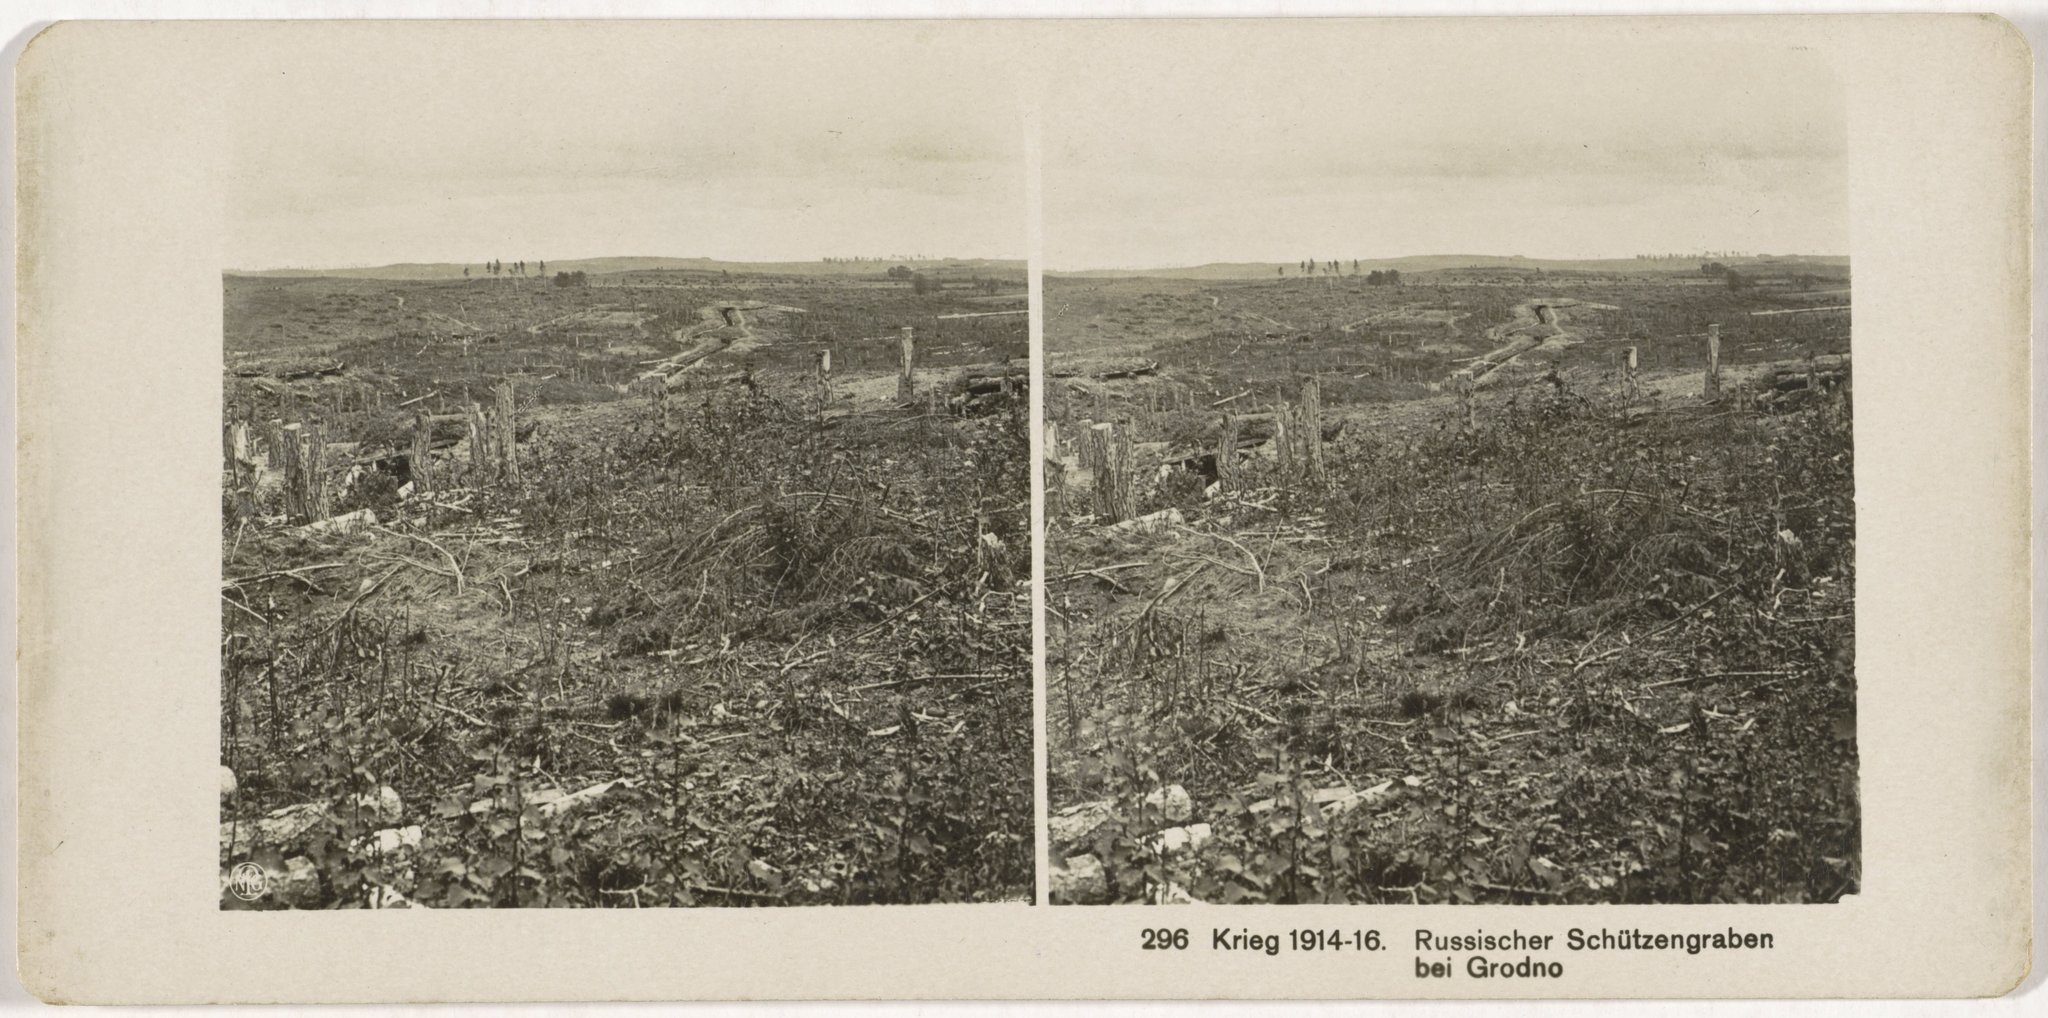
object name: stereograph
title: Russische loopgraven in de Eerste Wereldoorlog bij Grodno, Wit-Rusland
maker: Anonymous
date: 1916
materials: photographic support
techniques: gelatin silver print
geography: berlin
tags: war, trenches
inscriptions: number: ‘296’, stamp: ‘PERRY/ GALERIJ’